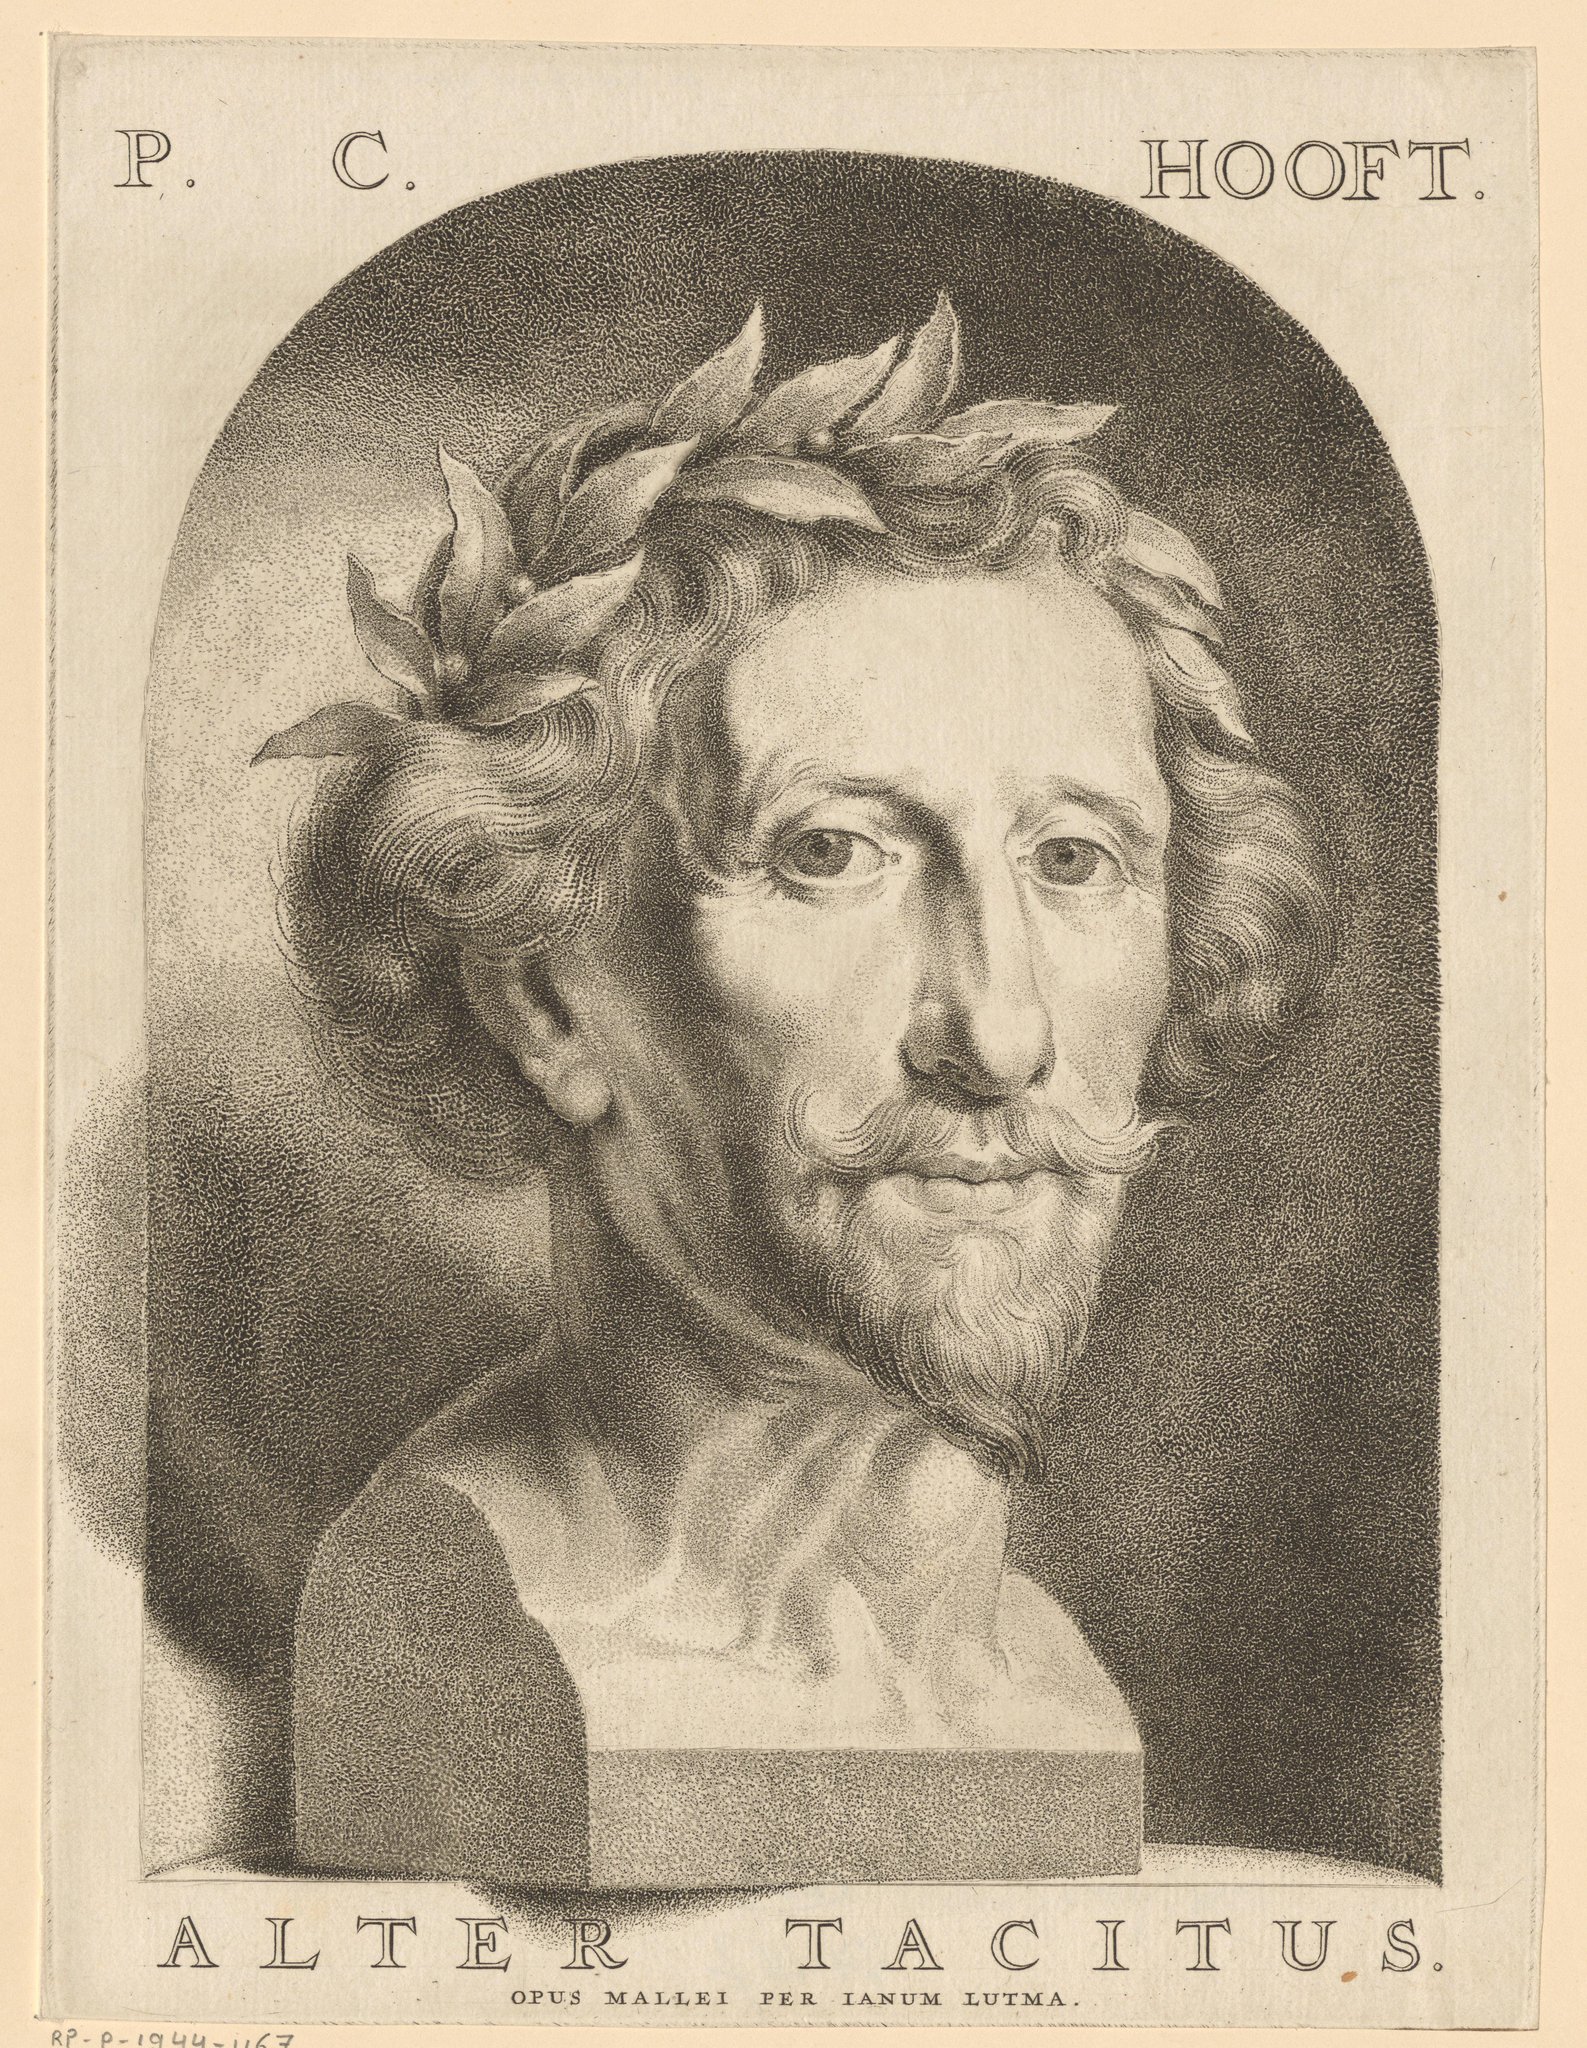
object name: print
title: Portret van Pieter Corneliszoon Hooft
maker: johannes lutma (1624-1689)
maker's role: print maker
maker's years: 1624-1689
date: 1634-1689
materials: paper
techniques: engraving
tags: amsterdam, the hague, pieter corneliszoon hooft, historical persons, writer, poet, author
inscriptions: collector's mark: Lugt 2228